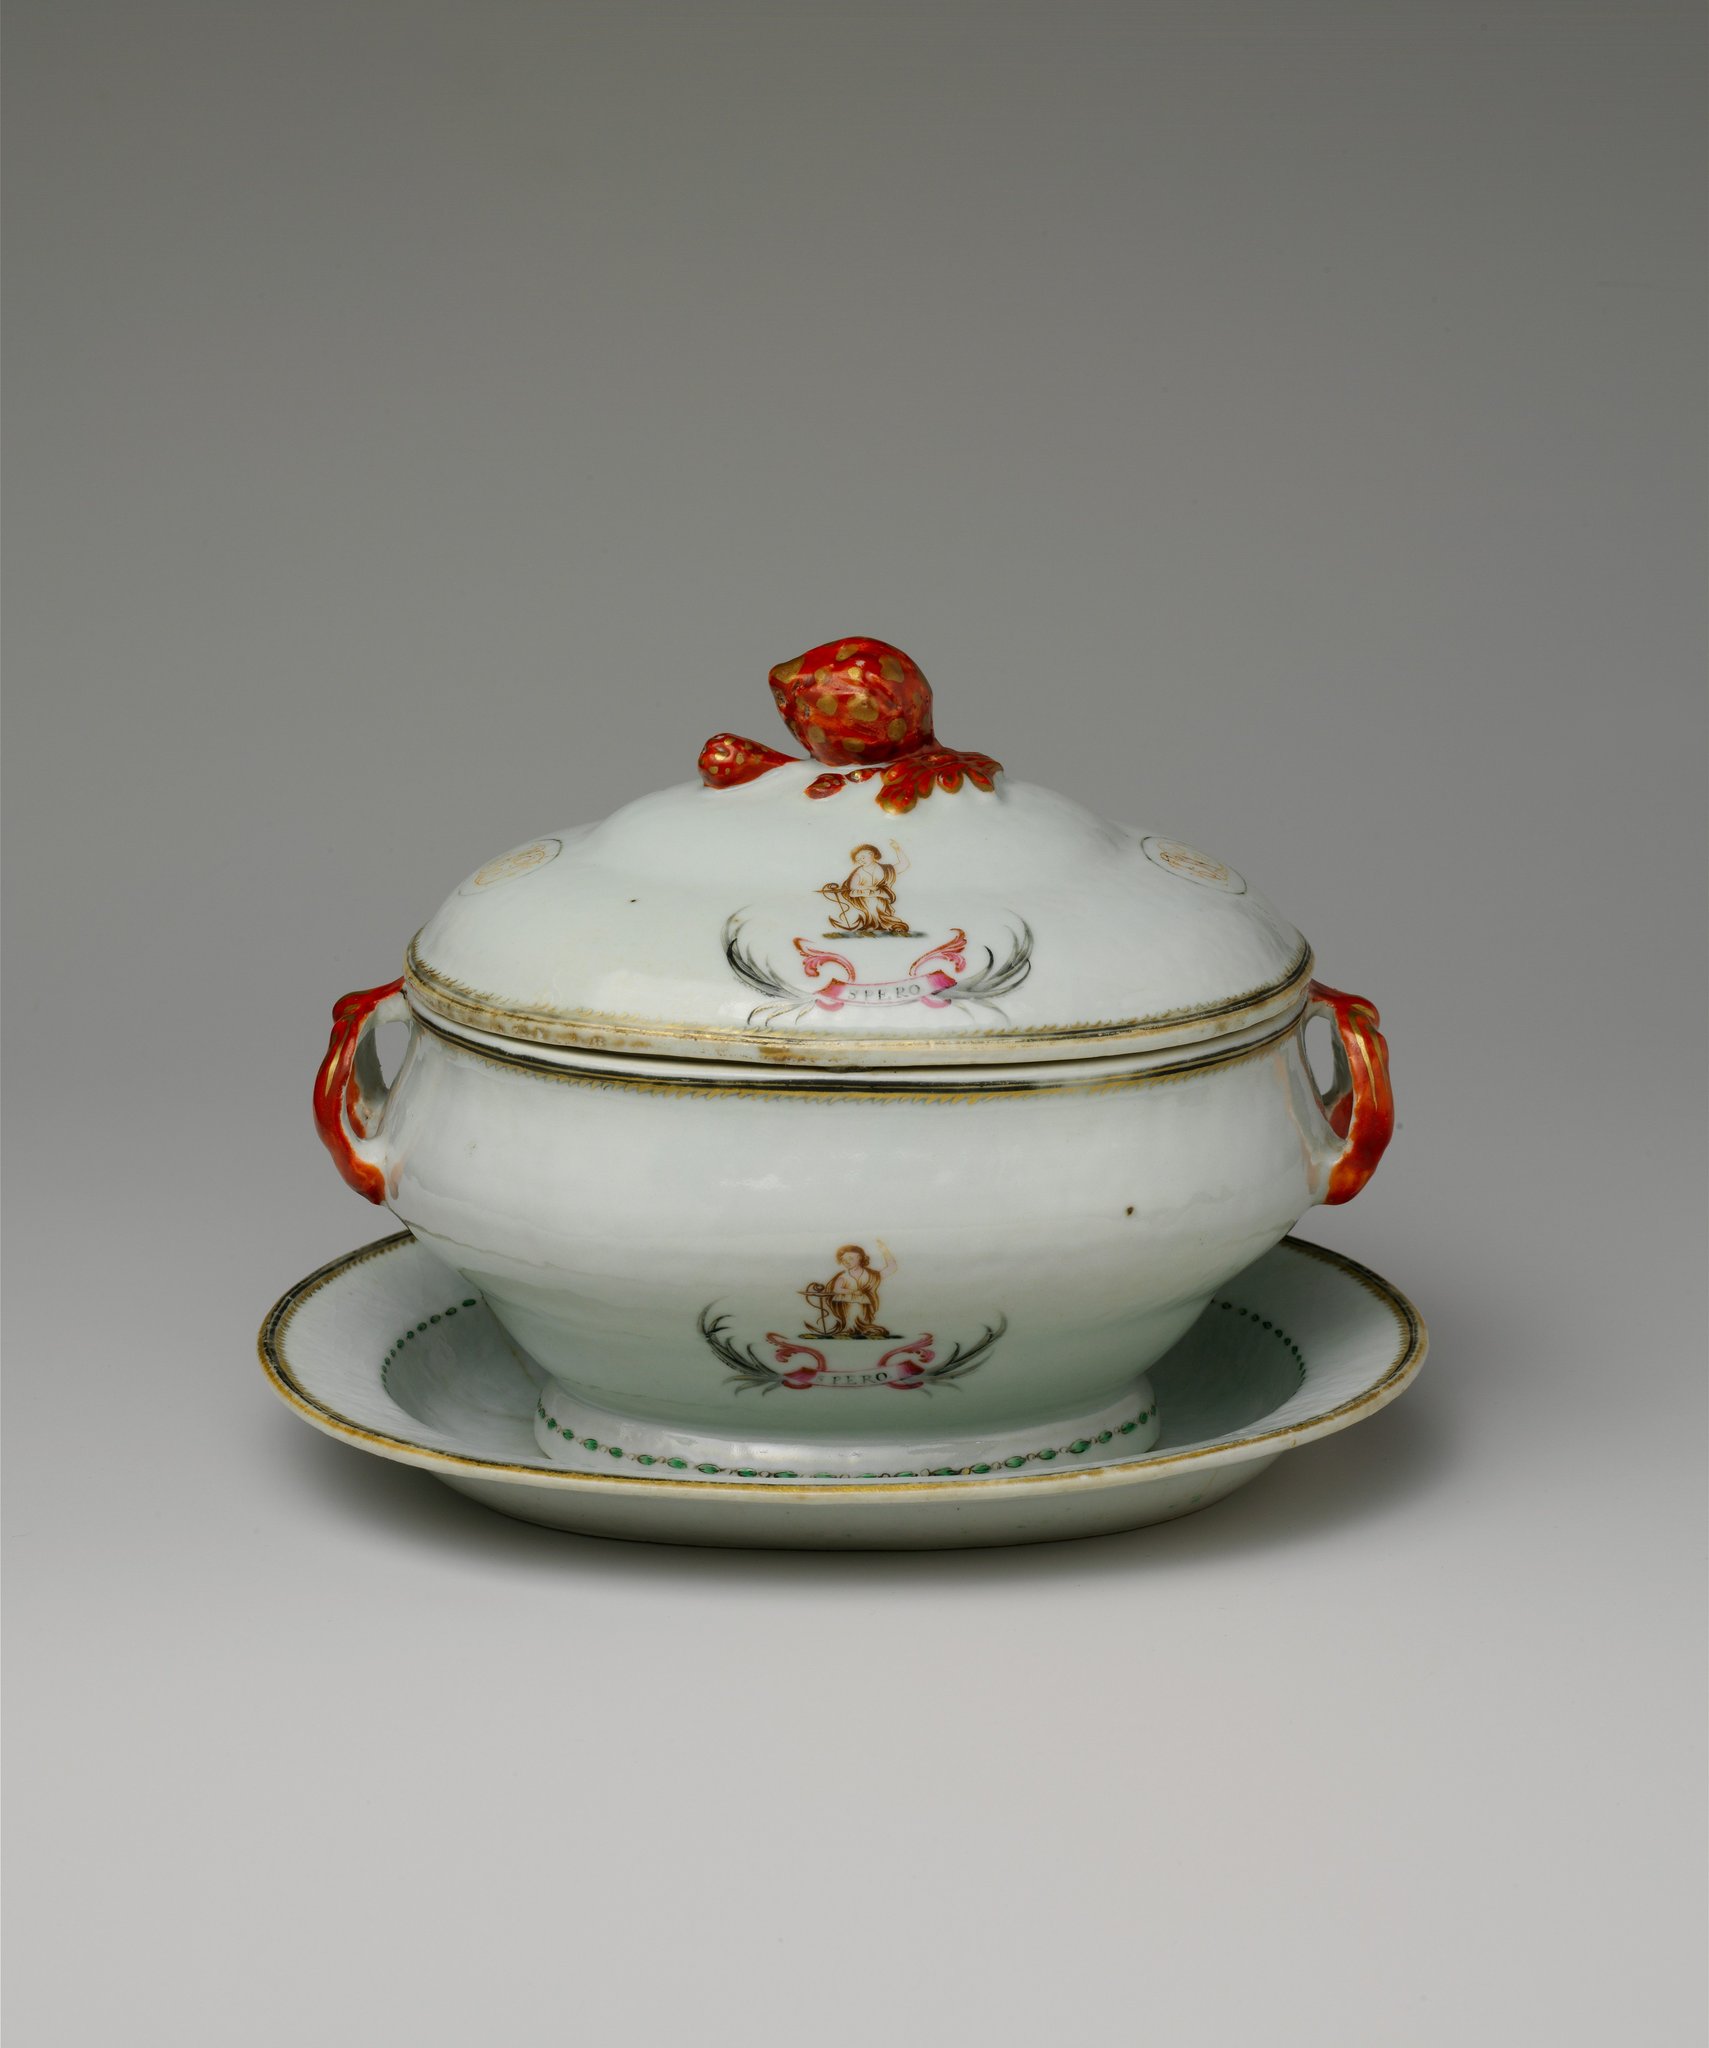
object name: sauce tureen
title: Covered Sauce Tureen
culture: chinese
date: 1786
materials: porcelain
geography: china